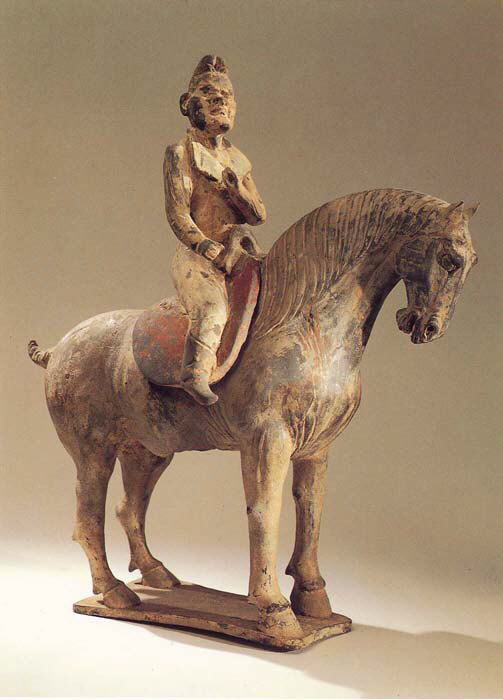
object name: figure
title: Horse and rider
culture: chinese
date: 601-800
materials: earthenware, pigment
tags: horses